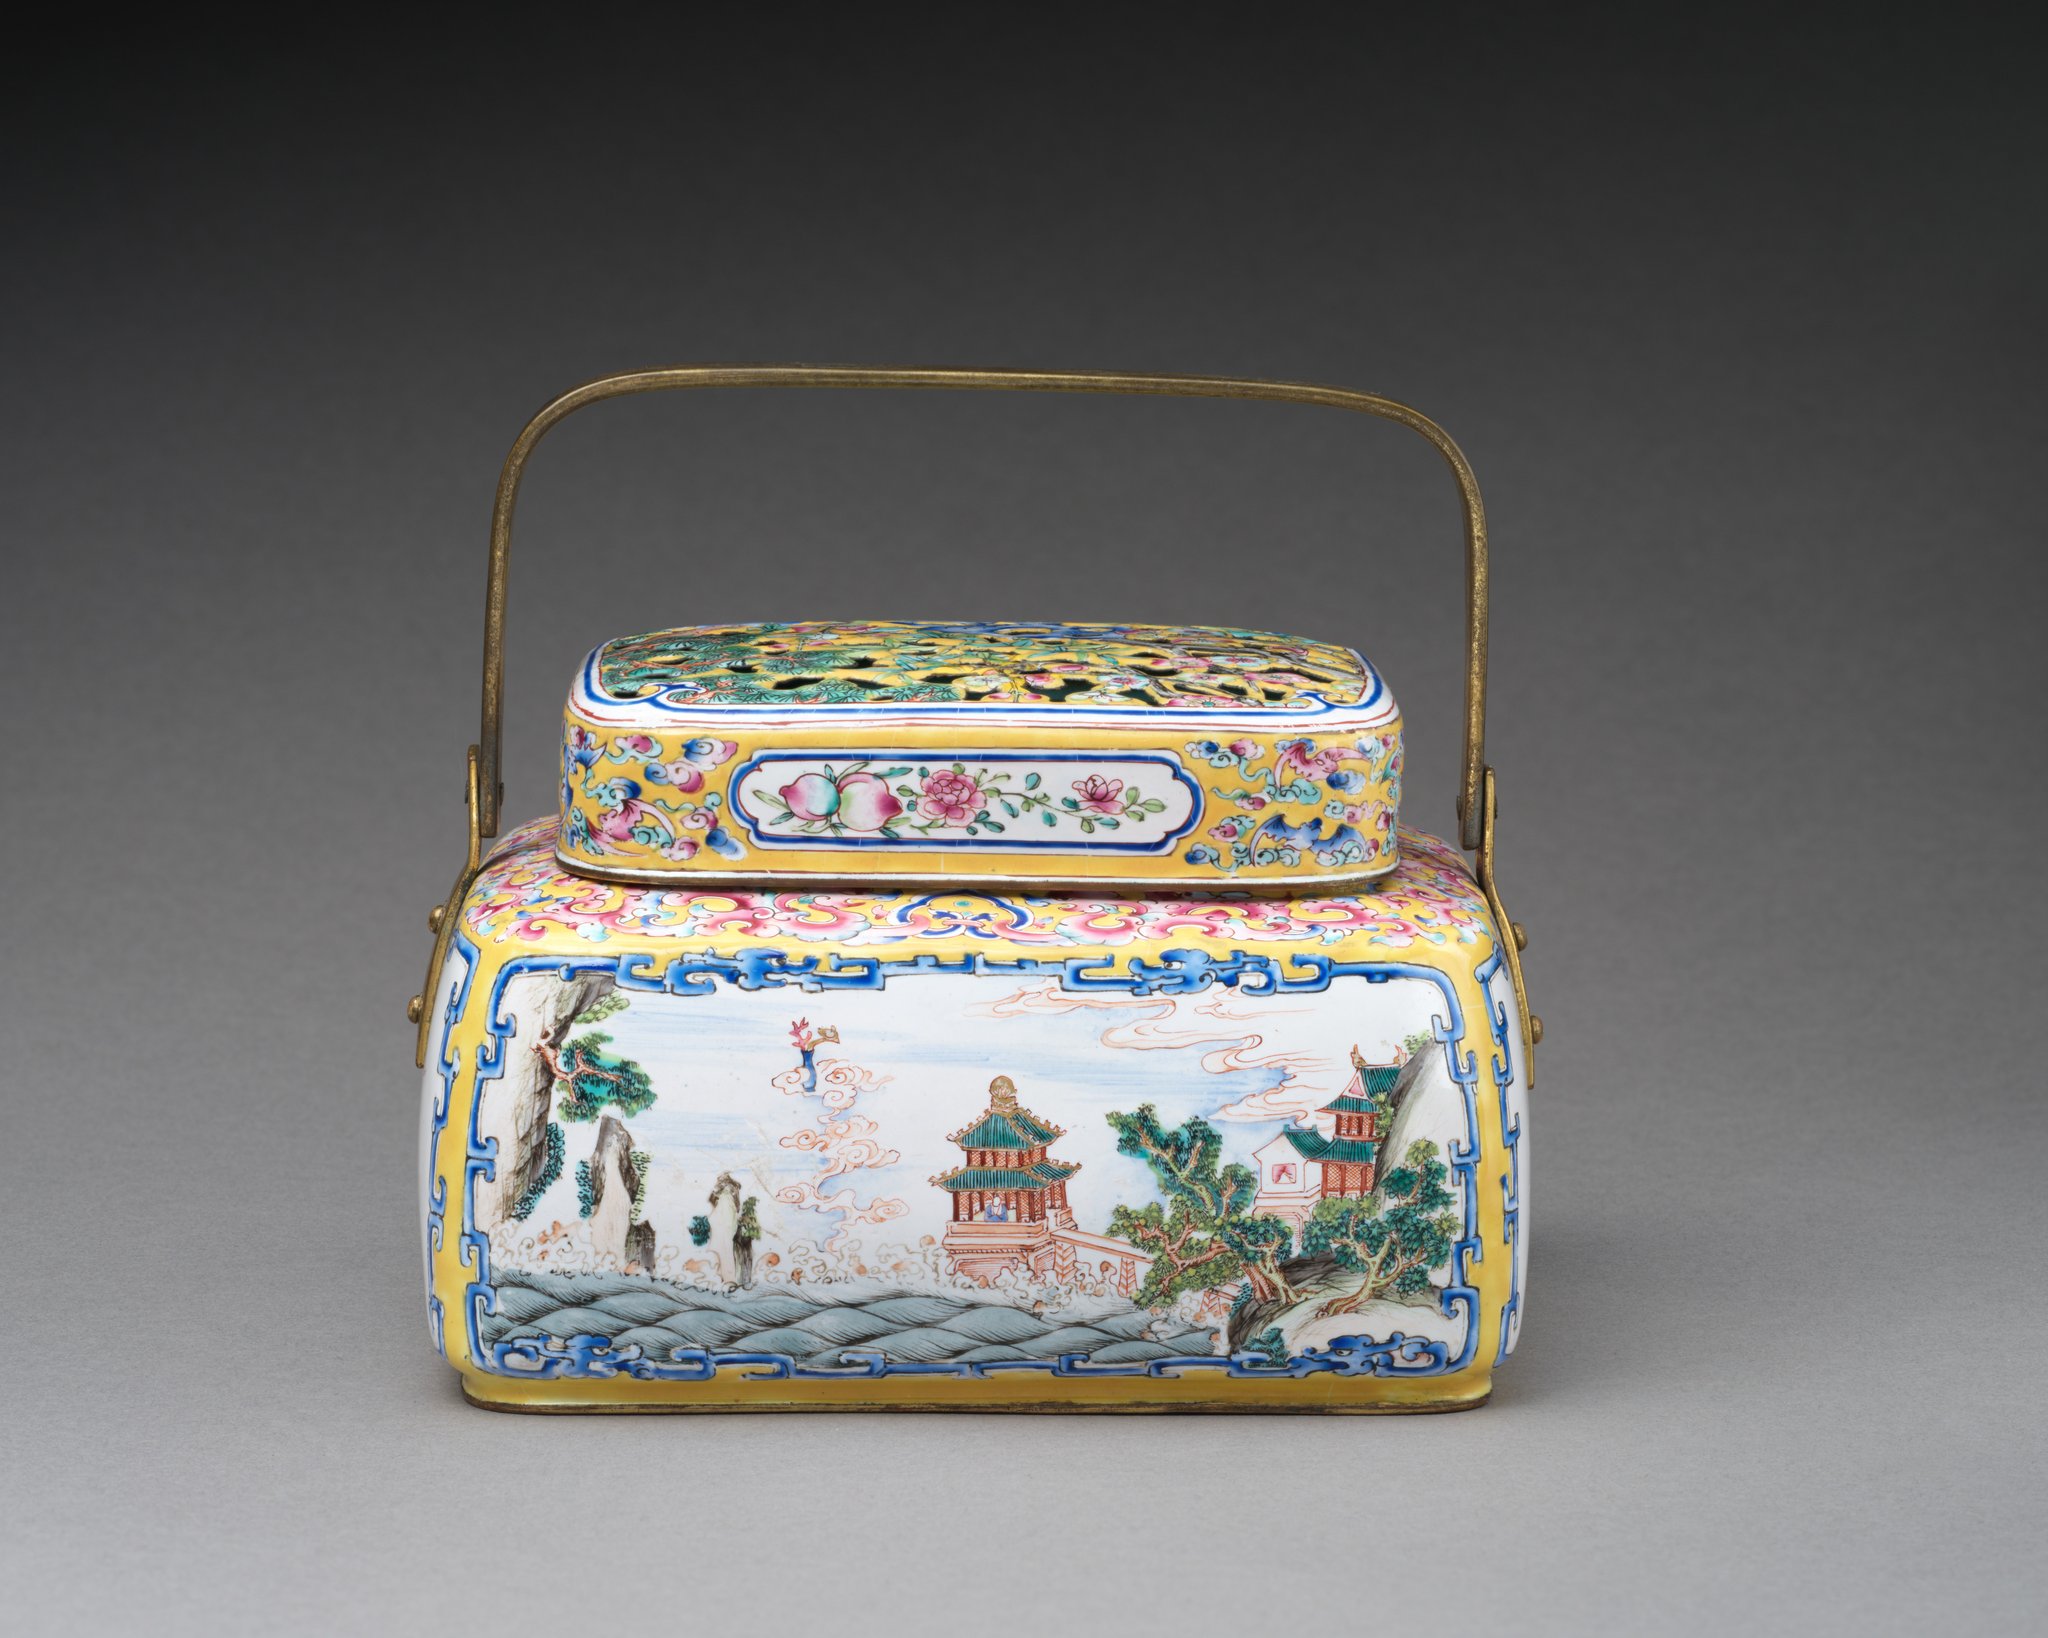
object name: hand warmer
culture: chinese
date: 1701-1800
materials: enamel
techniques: painting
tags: landscapes